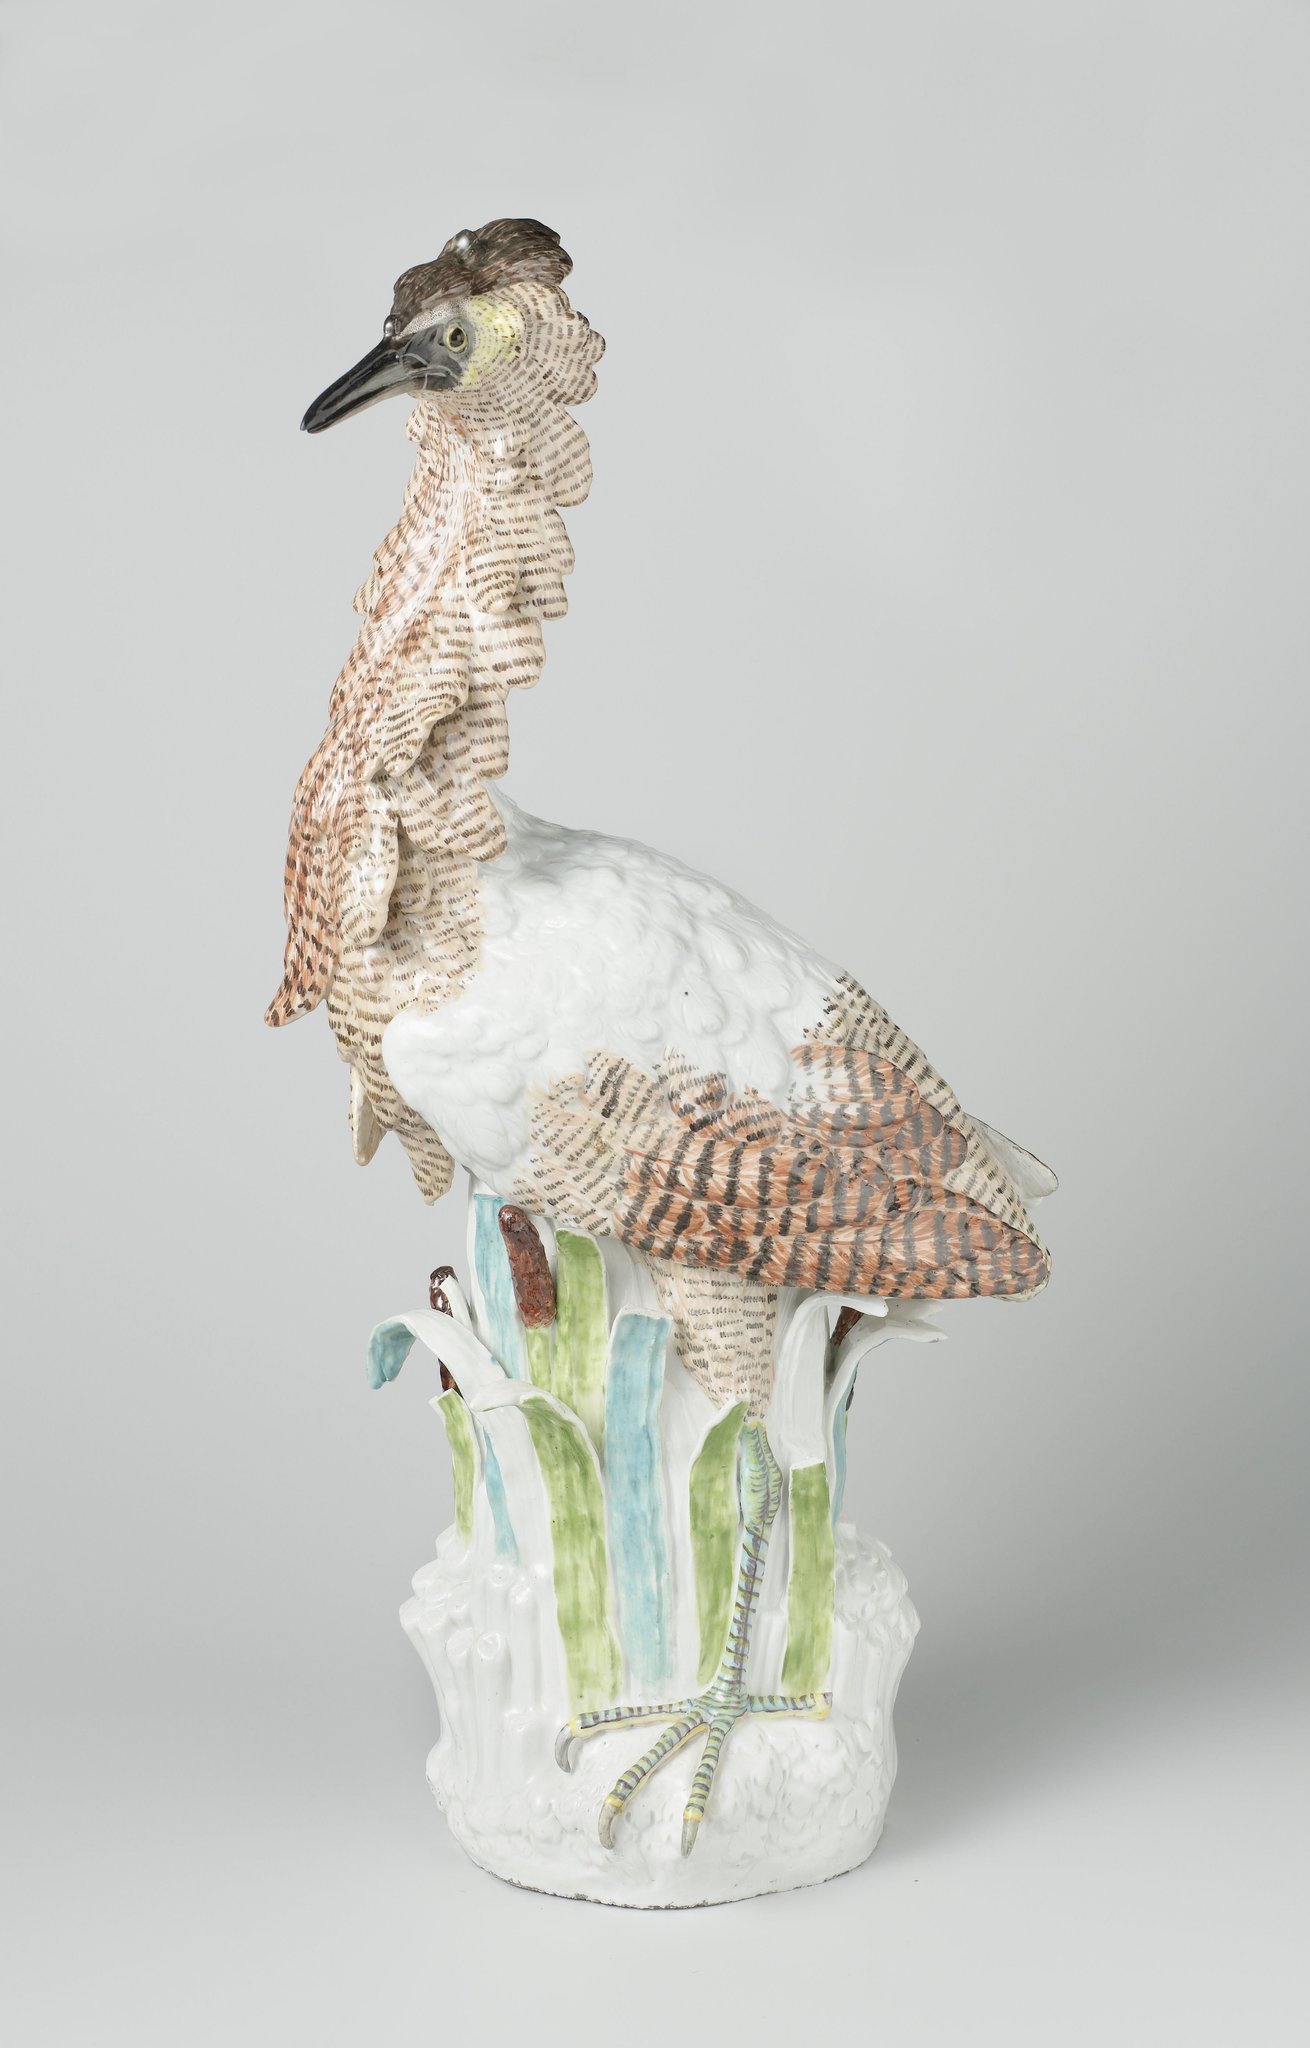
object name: figure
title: Bittern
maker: johann joachim kändler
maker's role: designer, sculptor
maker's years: 1706-1775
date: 1735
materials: porcelain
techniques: painted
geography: meissen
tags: shore-birds and wading-birds: bittern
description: The porcelain factory at Meissen, near Dresden, was founded in 1709. It was the first European factory to produce ‘true’ or hard-paste porcelain, like that known in China and Japan. The manufactory was owned by Augustus the Strong, Elector of Saxony and King of Poland. All the birds and animals in this display case were made for him. They were intended for his so-called Japanese Palace, the walls of which he wished to fill with porcelain.